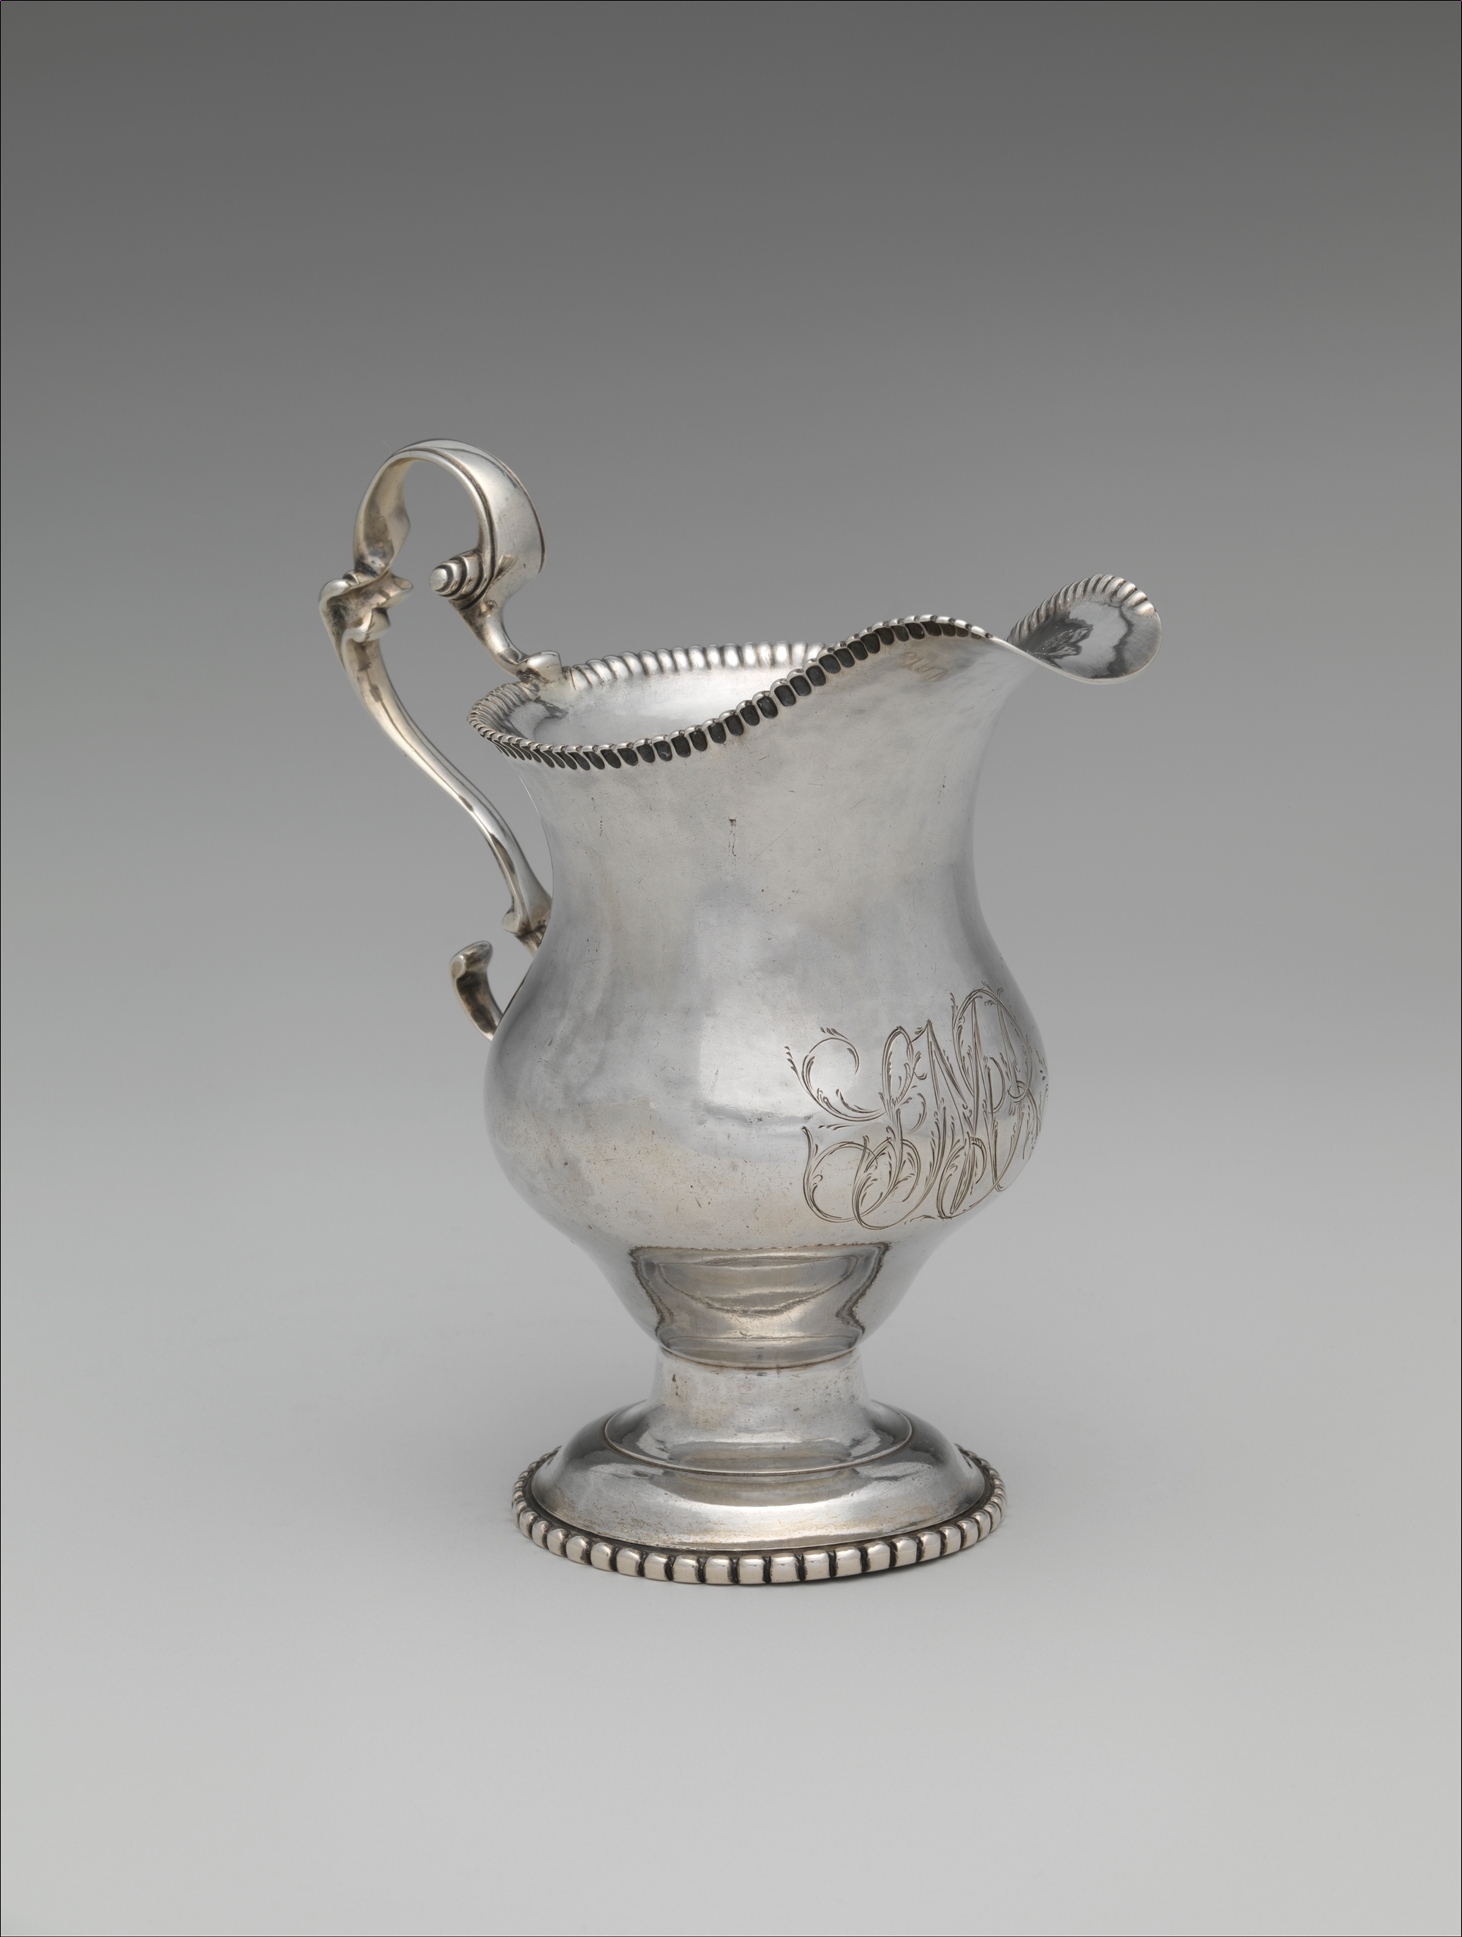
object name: cream pot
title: Creamer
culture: american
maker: john letelier sr.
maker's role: maker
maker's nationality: american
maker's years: 1740-1798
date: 1770-1795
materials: silver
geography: united states